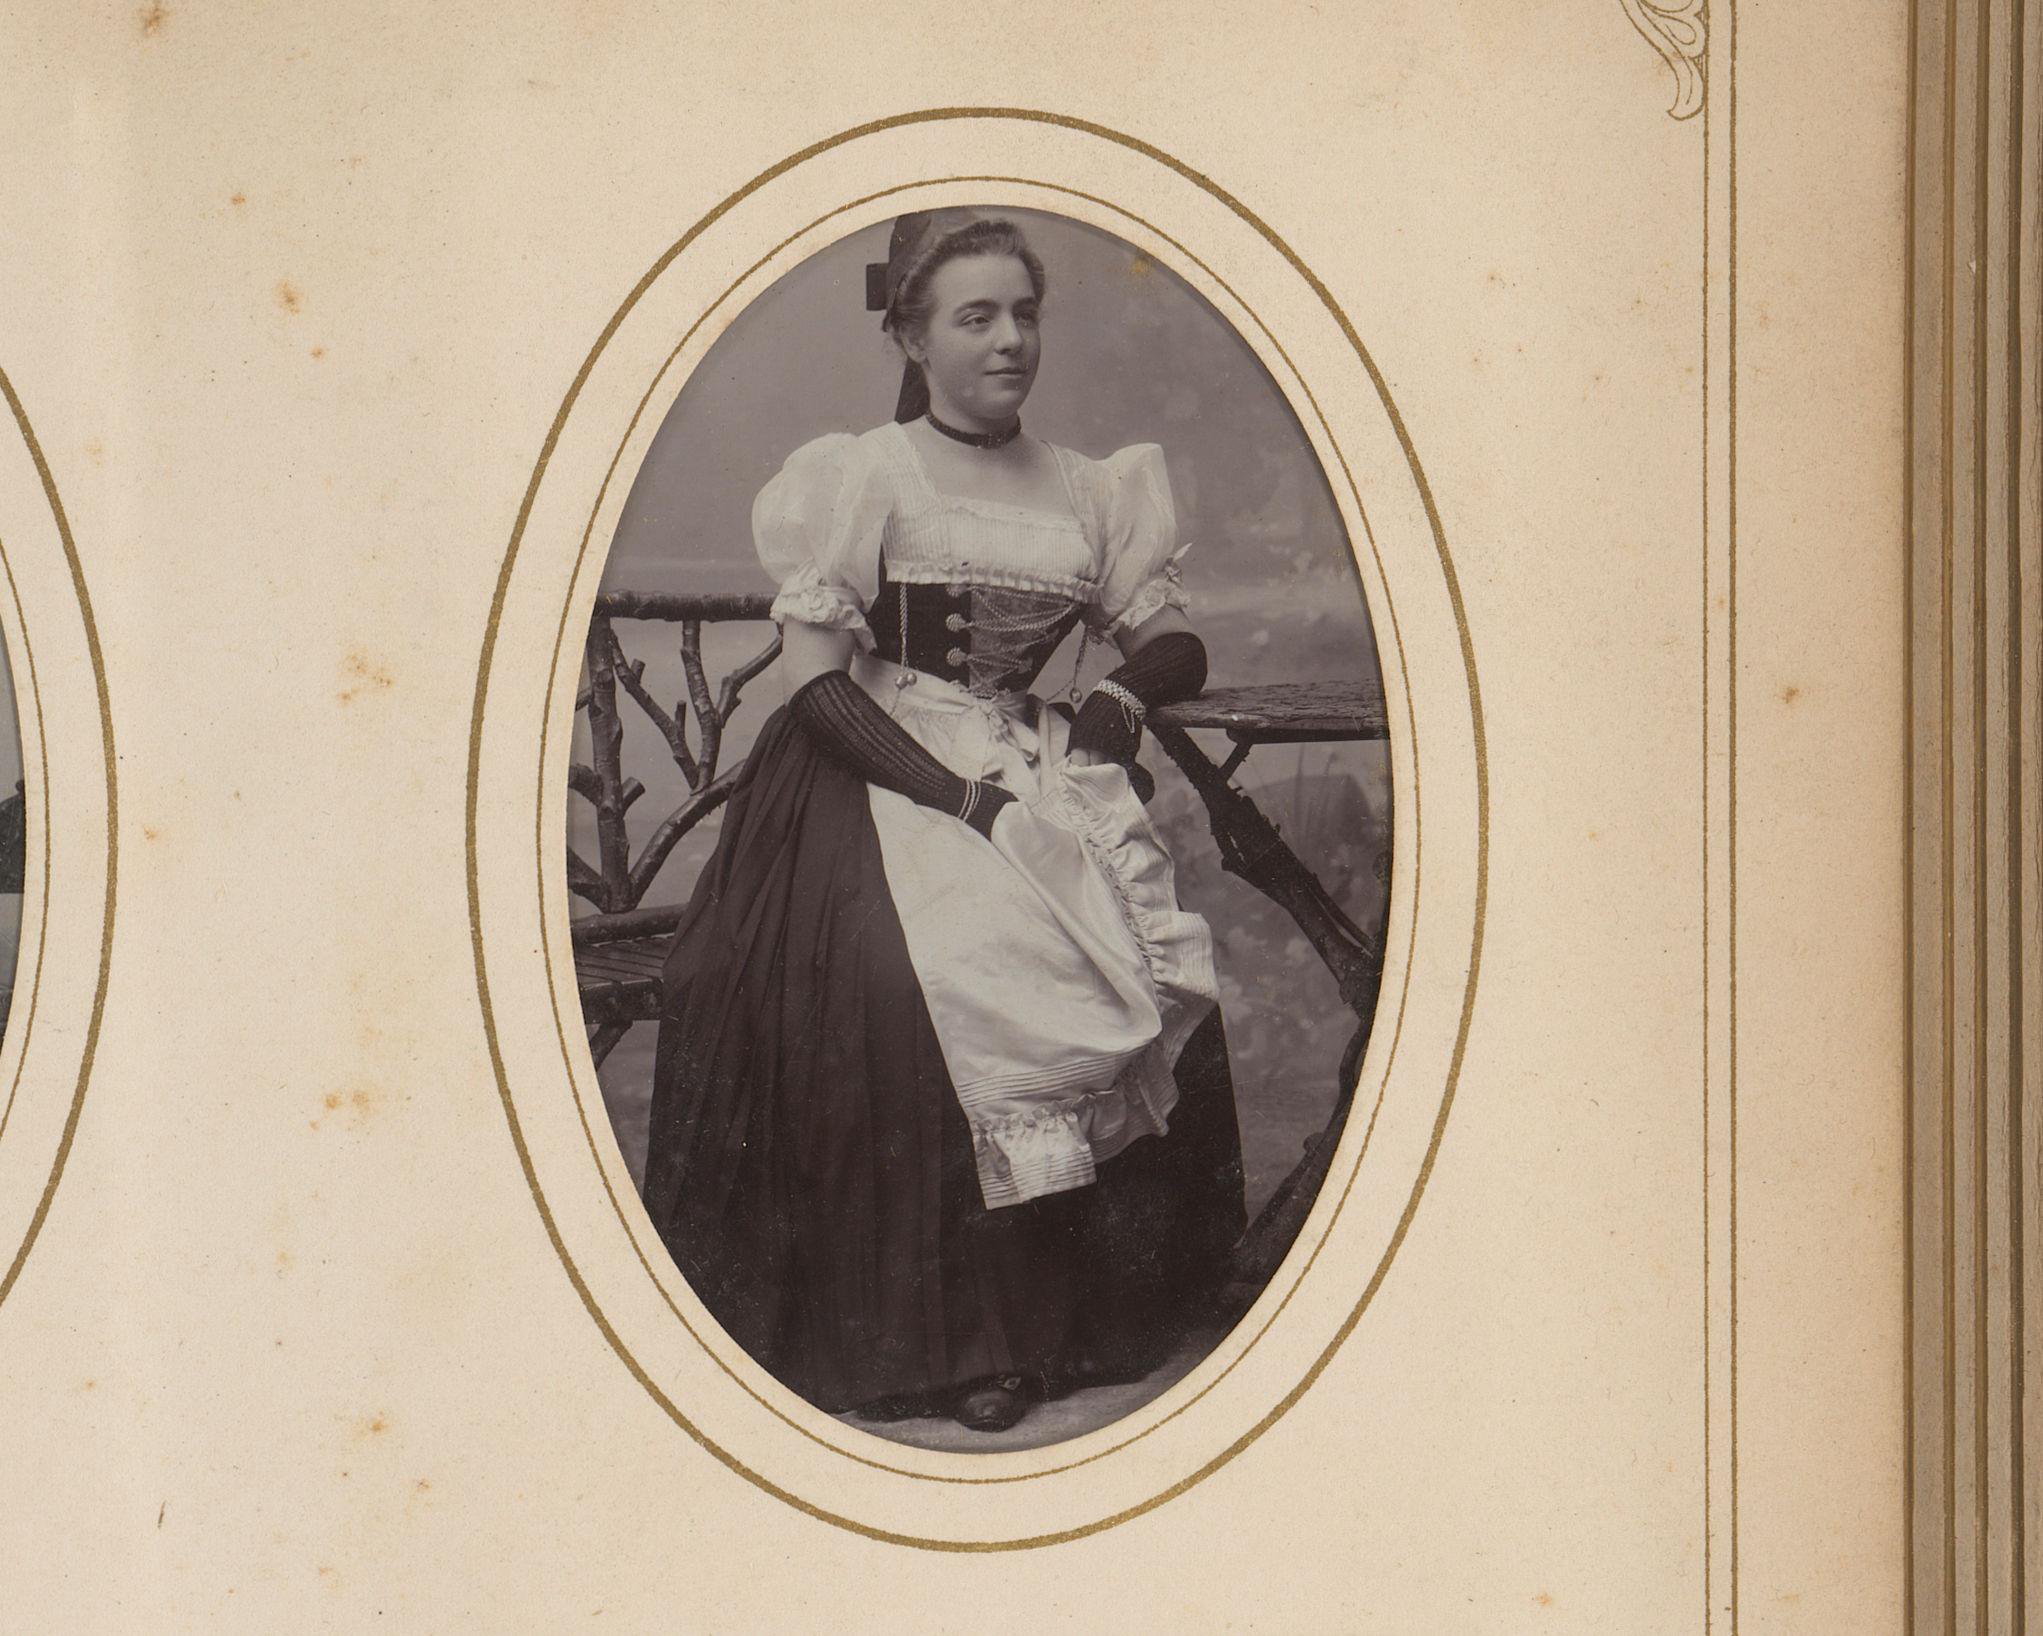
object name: carte de visite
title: Portret van een vrouw, zittend aan een tafel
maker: f. salmon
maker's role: fotograaf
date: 1880-1940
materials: cardboard, photographic support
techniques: collodion silver print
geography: frankenthal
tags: sitting figure - aa - female human figure, historical persons - bb - woman, table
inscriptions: inscription: ‘FS/ F. Salmon/ Frankenthal i/pf./ Westl. Ringstr. 8./ Atelier gegenüber. dem/ Bahnhof./ Die Platte bleibt aufbewahrt.’